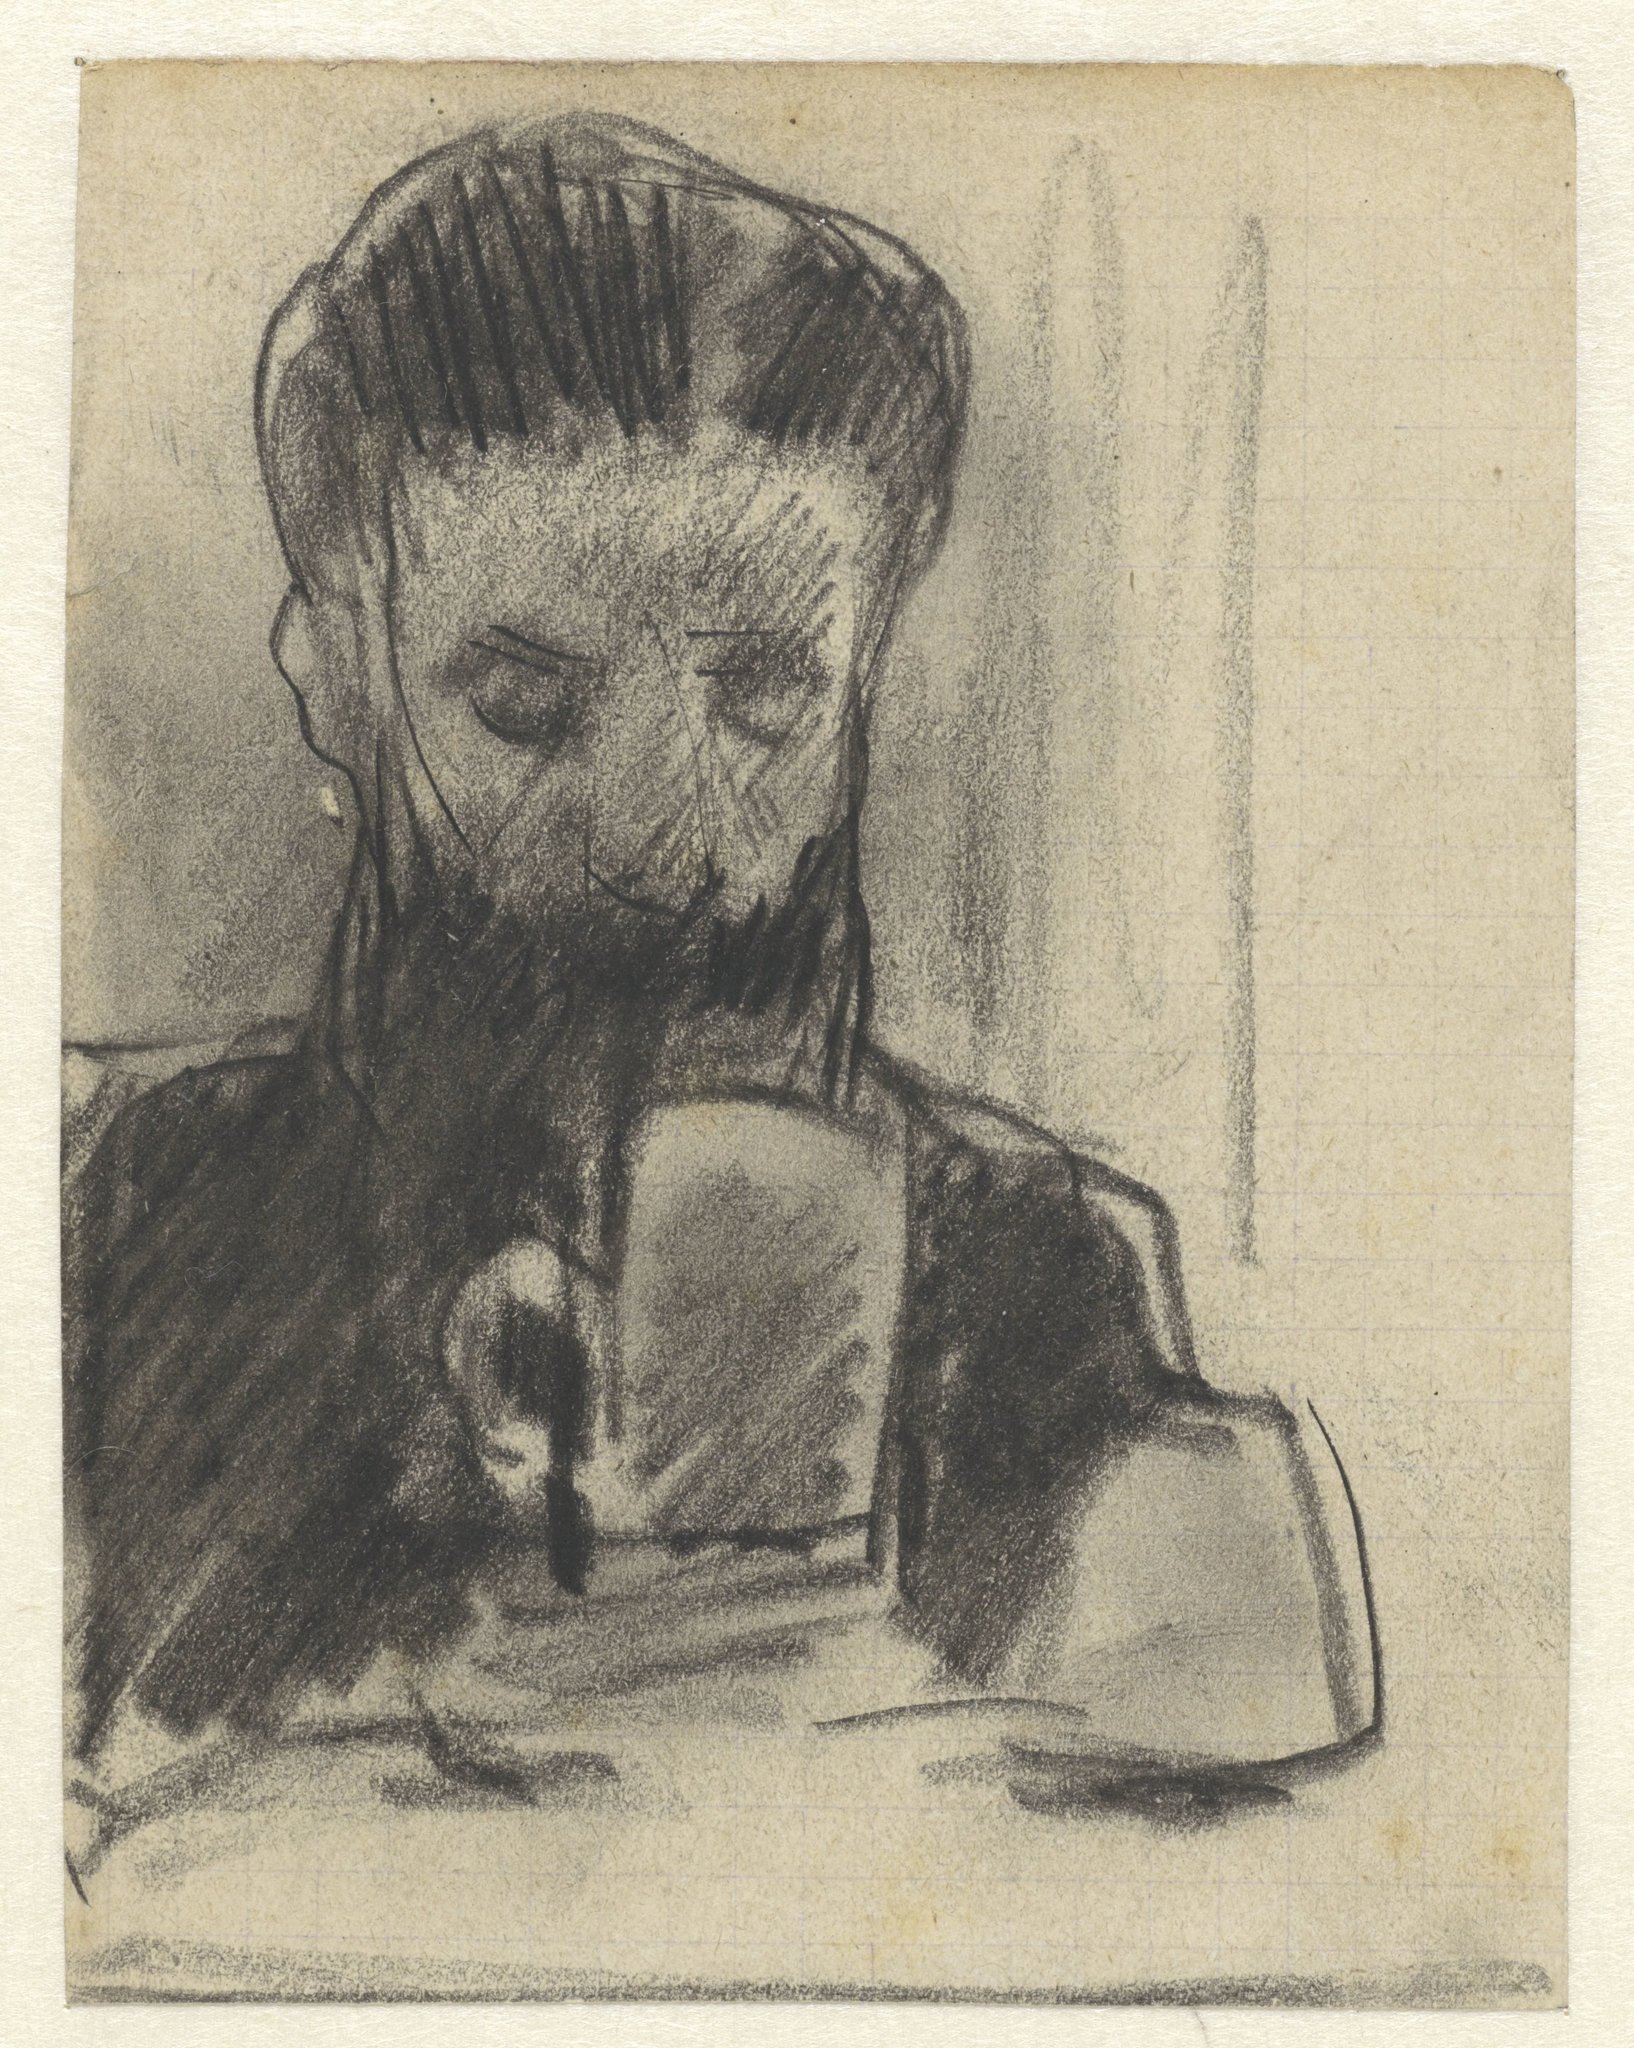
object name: drawing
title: Man met bierpul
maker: jac van looij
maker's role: draughtsman, painter, print maker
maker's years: 1855-1930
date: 1865-1930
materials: chalk